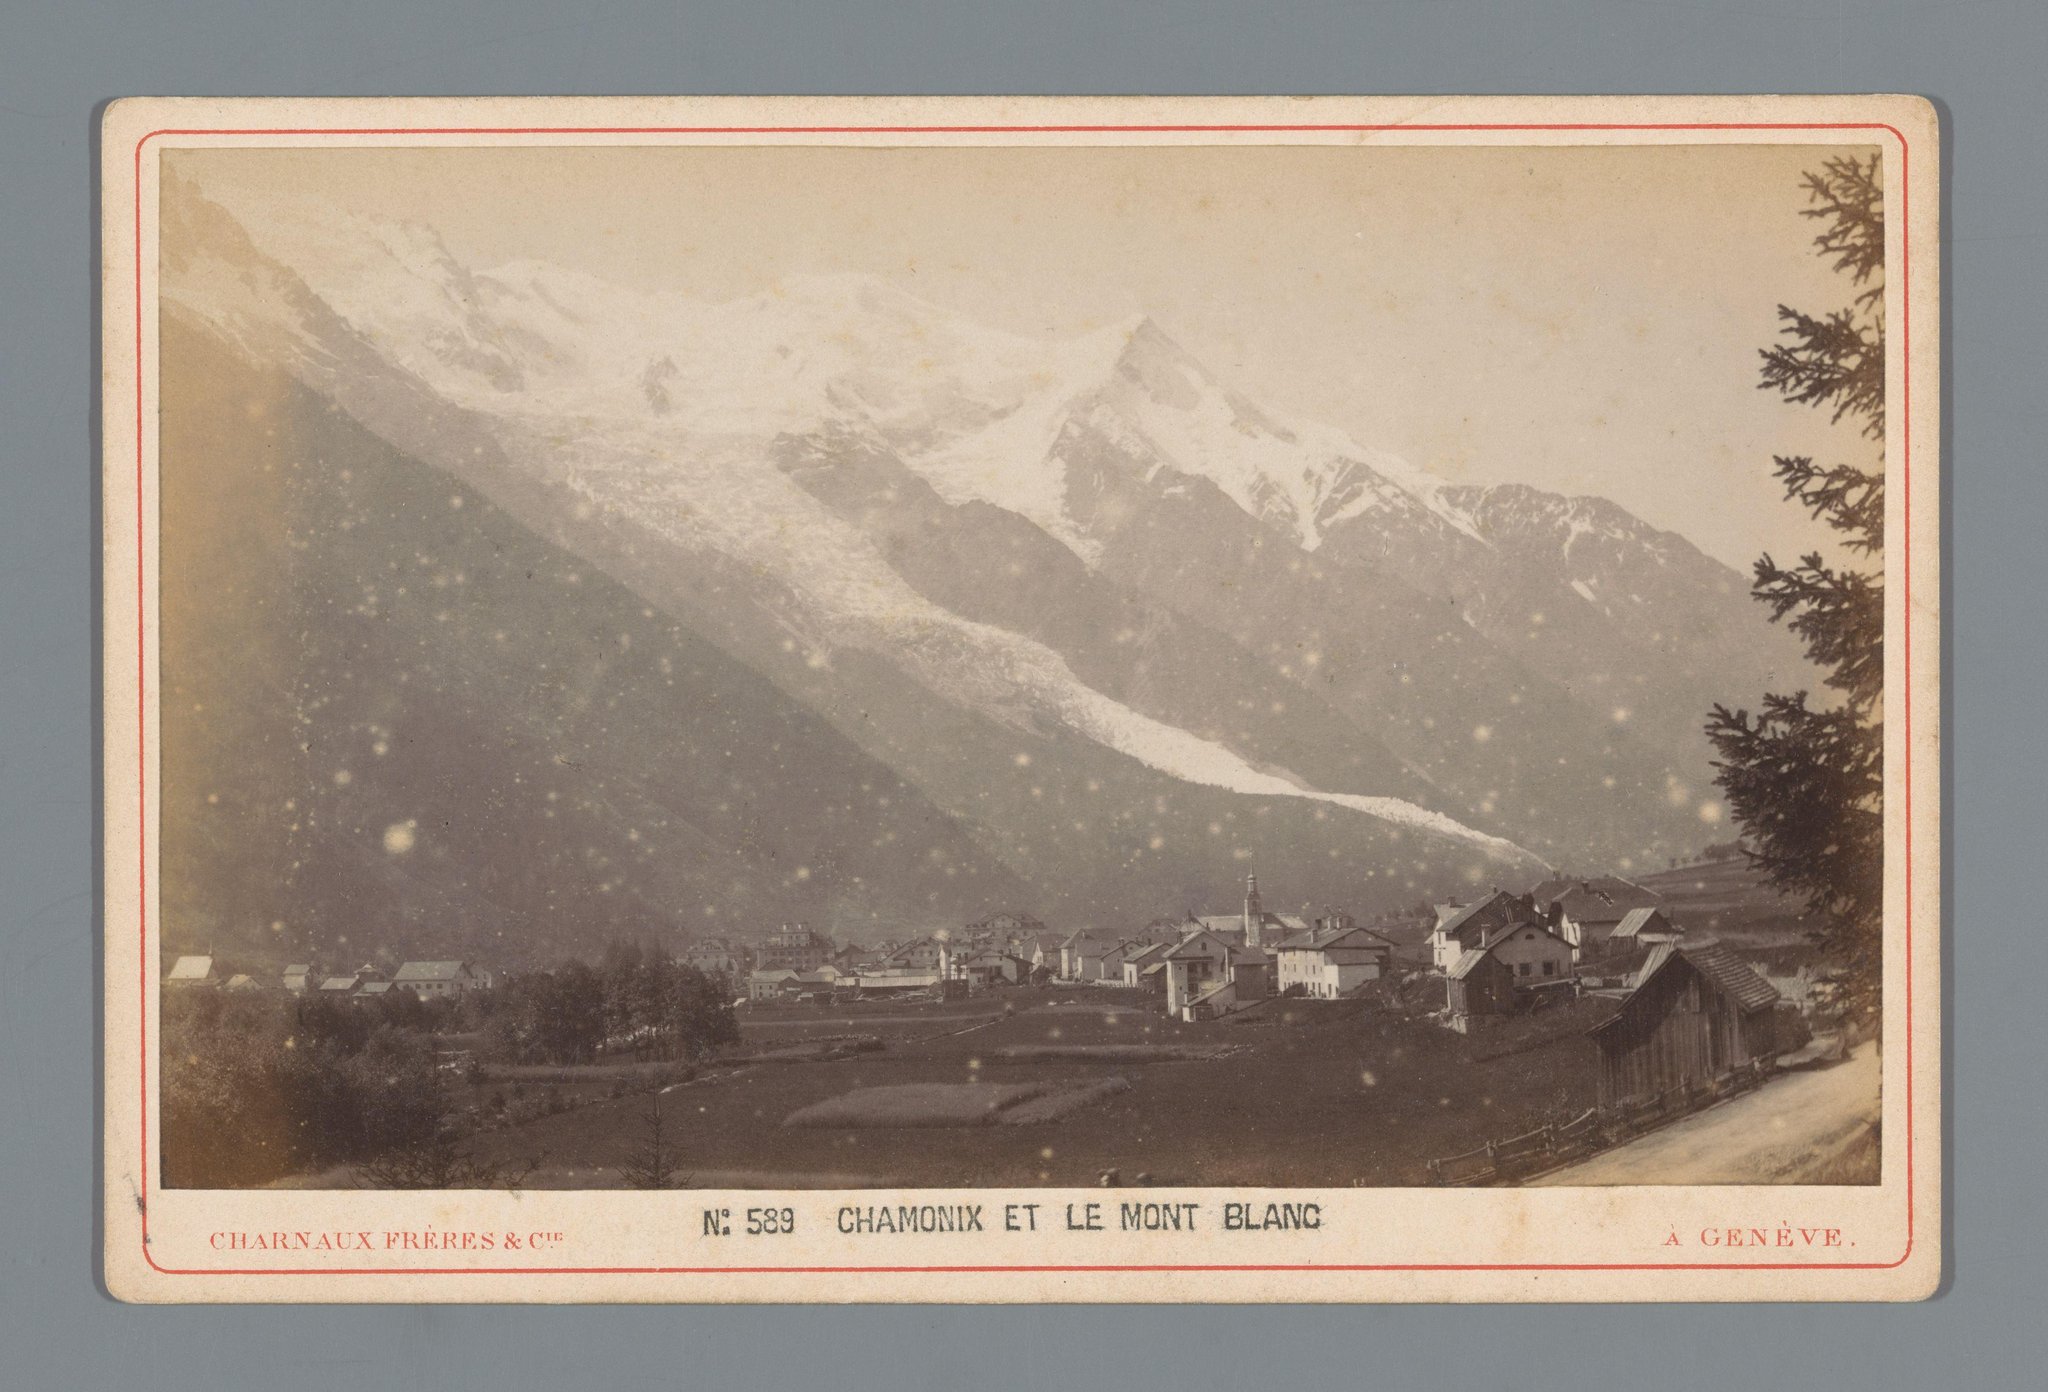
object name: cabinet photograph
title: Gezicht op Chamonix met bergen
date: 1870-1900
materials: cardboard, photographic support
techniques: albumen print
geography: chamonix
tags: city-view in general; 'veduta', mountains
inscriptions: workshop stamp: ‘Maison des trois rois/ Ancienne Maison F. Charnaux/ (...)’, inscription: ‘A Geneve’, number: ‘N.589’